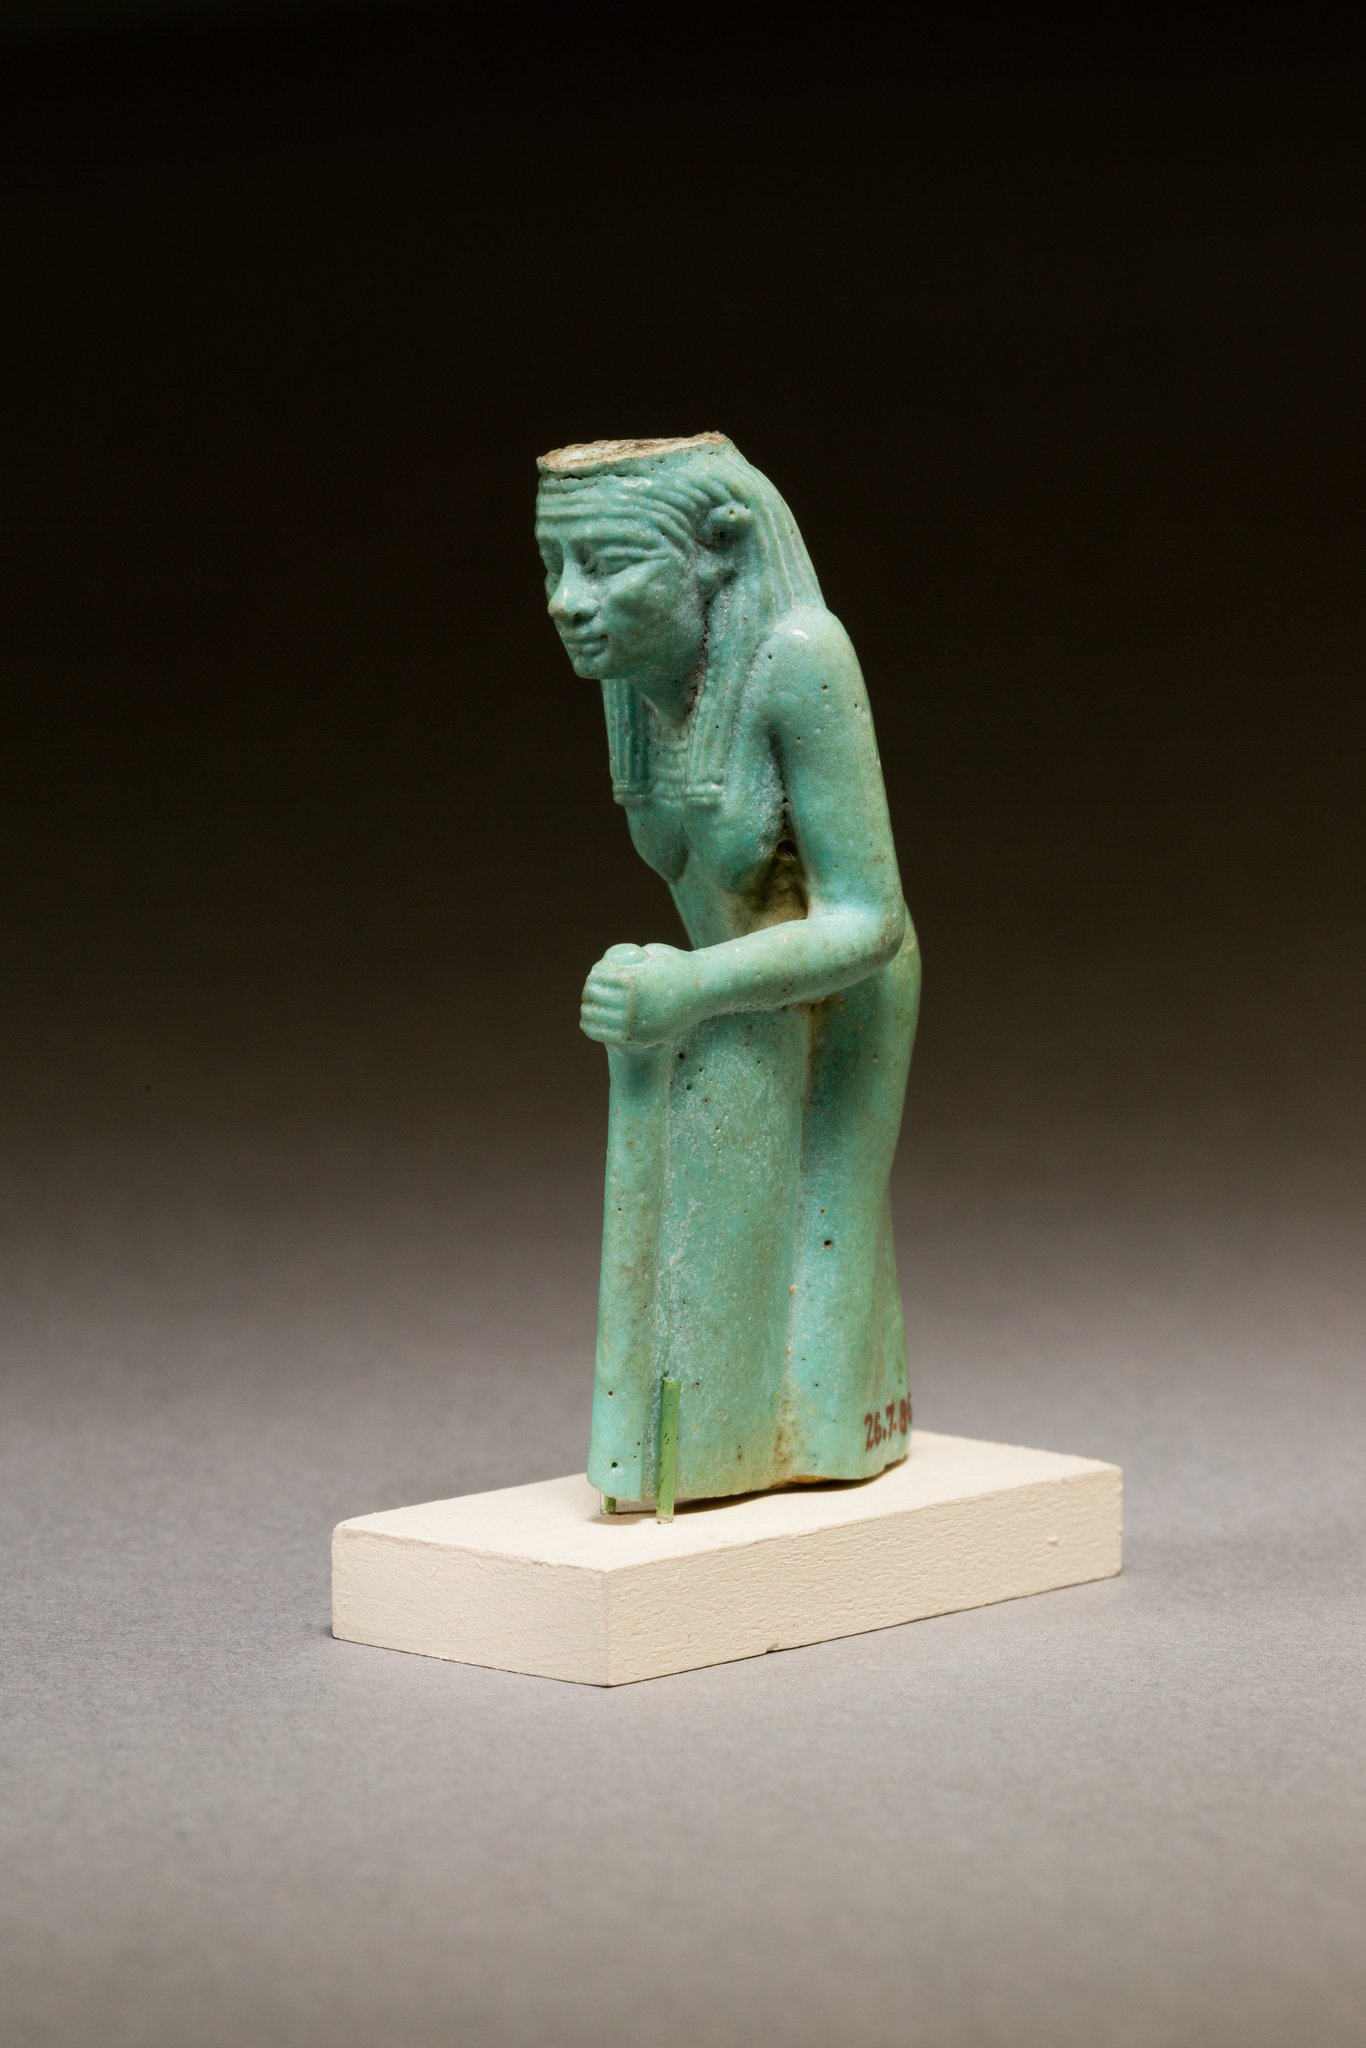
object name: statuette, woman, worn, staff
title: Statuette of a worn or aged woman, probably a goddess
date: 664-630 BCE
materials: faience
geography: egypt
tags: goddess